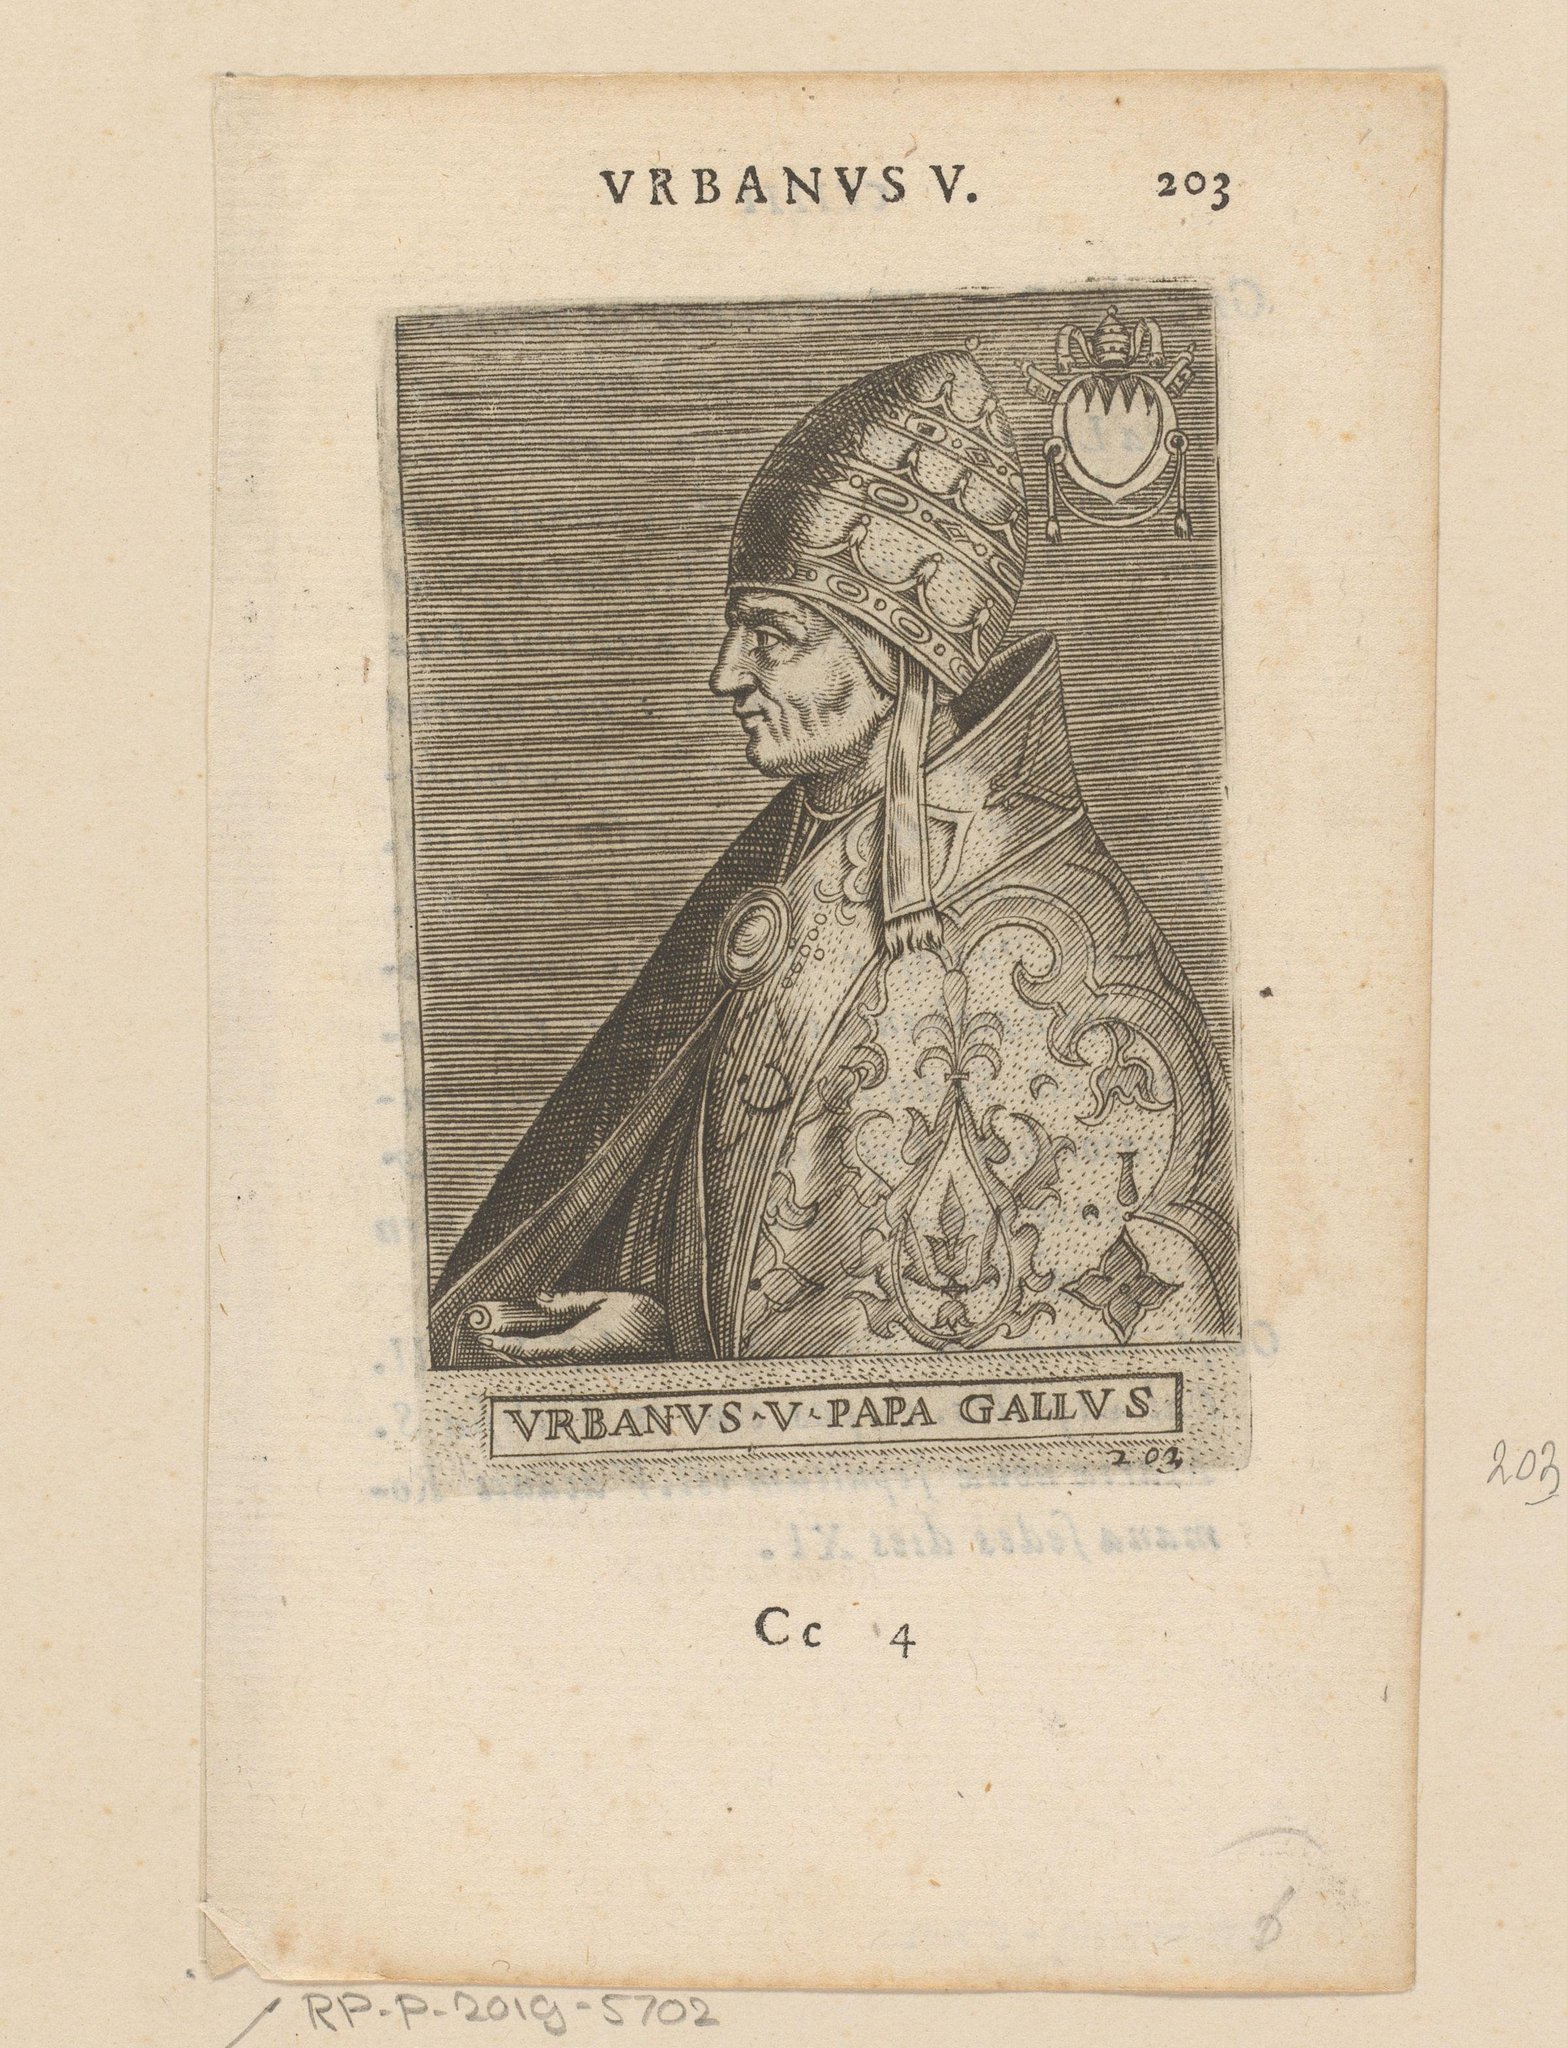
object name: book illustration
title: Portret van paus Urbanus V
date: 1595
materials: paper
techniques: engraving, letterpress printing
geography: rome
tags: historical persons, pope, armorial bearing, heraldry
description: Prent uit: Cavalieri, Giovanni Battista de'. Effigies pontificum romanorum cum eorum vitis (...). Rome: Bartolomeo Bonfadino, 1595. Prent voor het eerst verschenen in: Cavalieri, Giovanni Battista de'. Pontificum romanorum effigies (...). Rome: Domenico Basa en Francesco Zanetti, 1580. Prent ook gebruikt in latere publicaties.